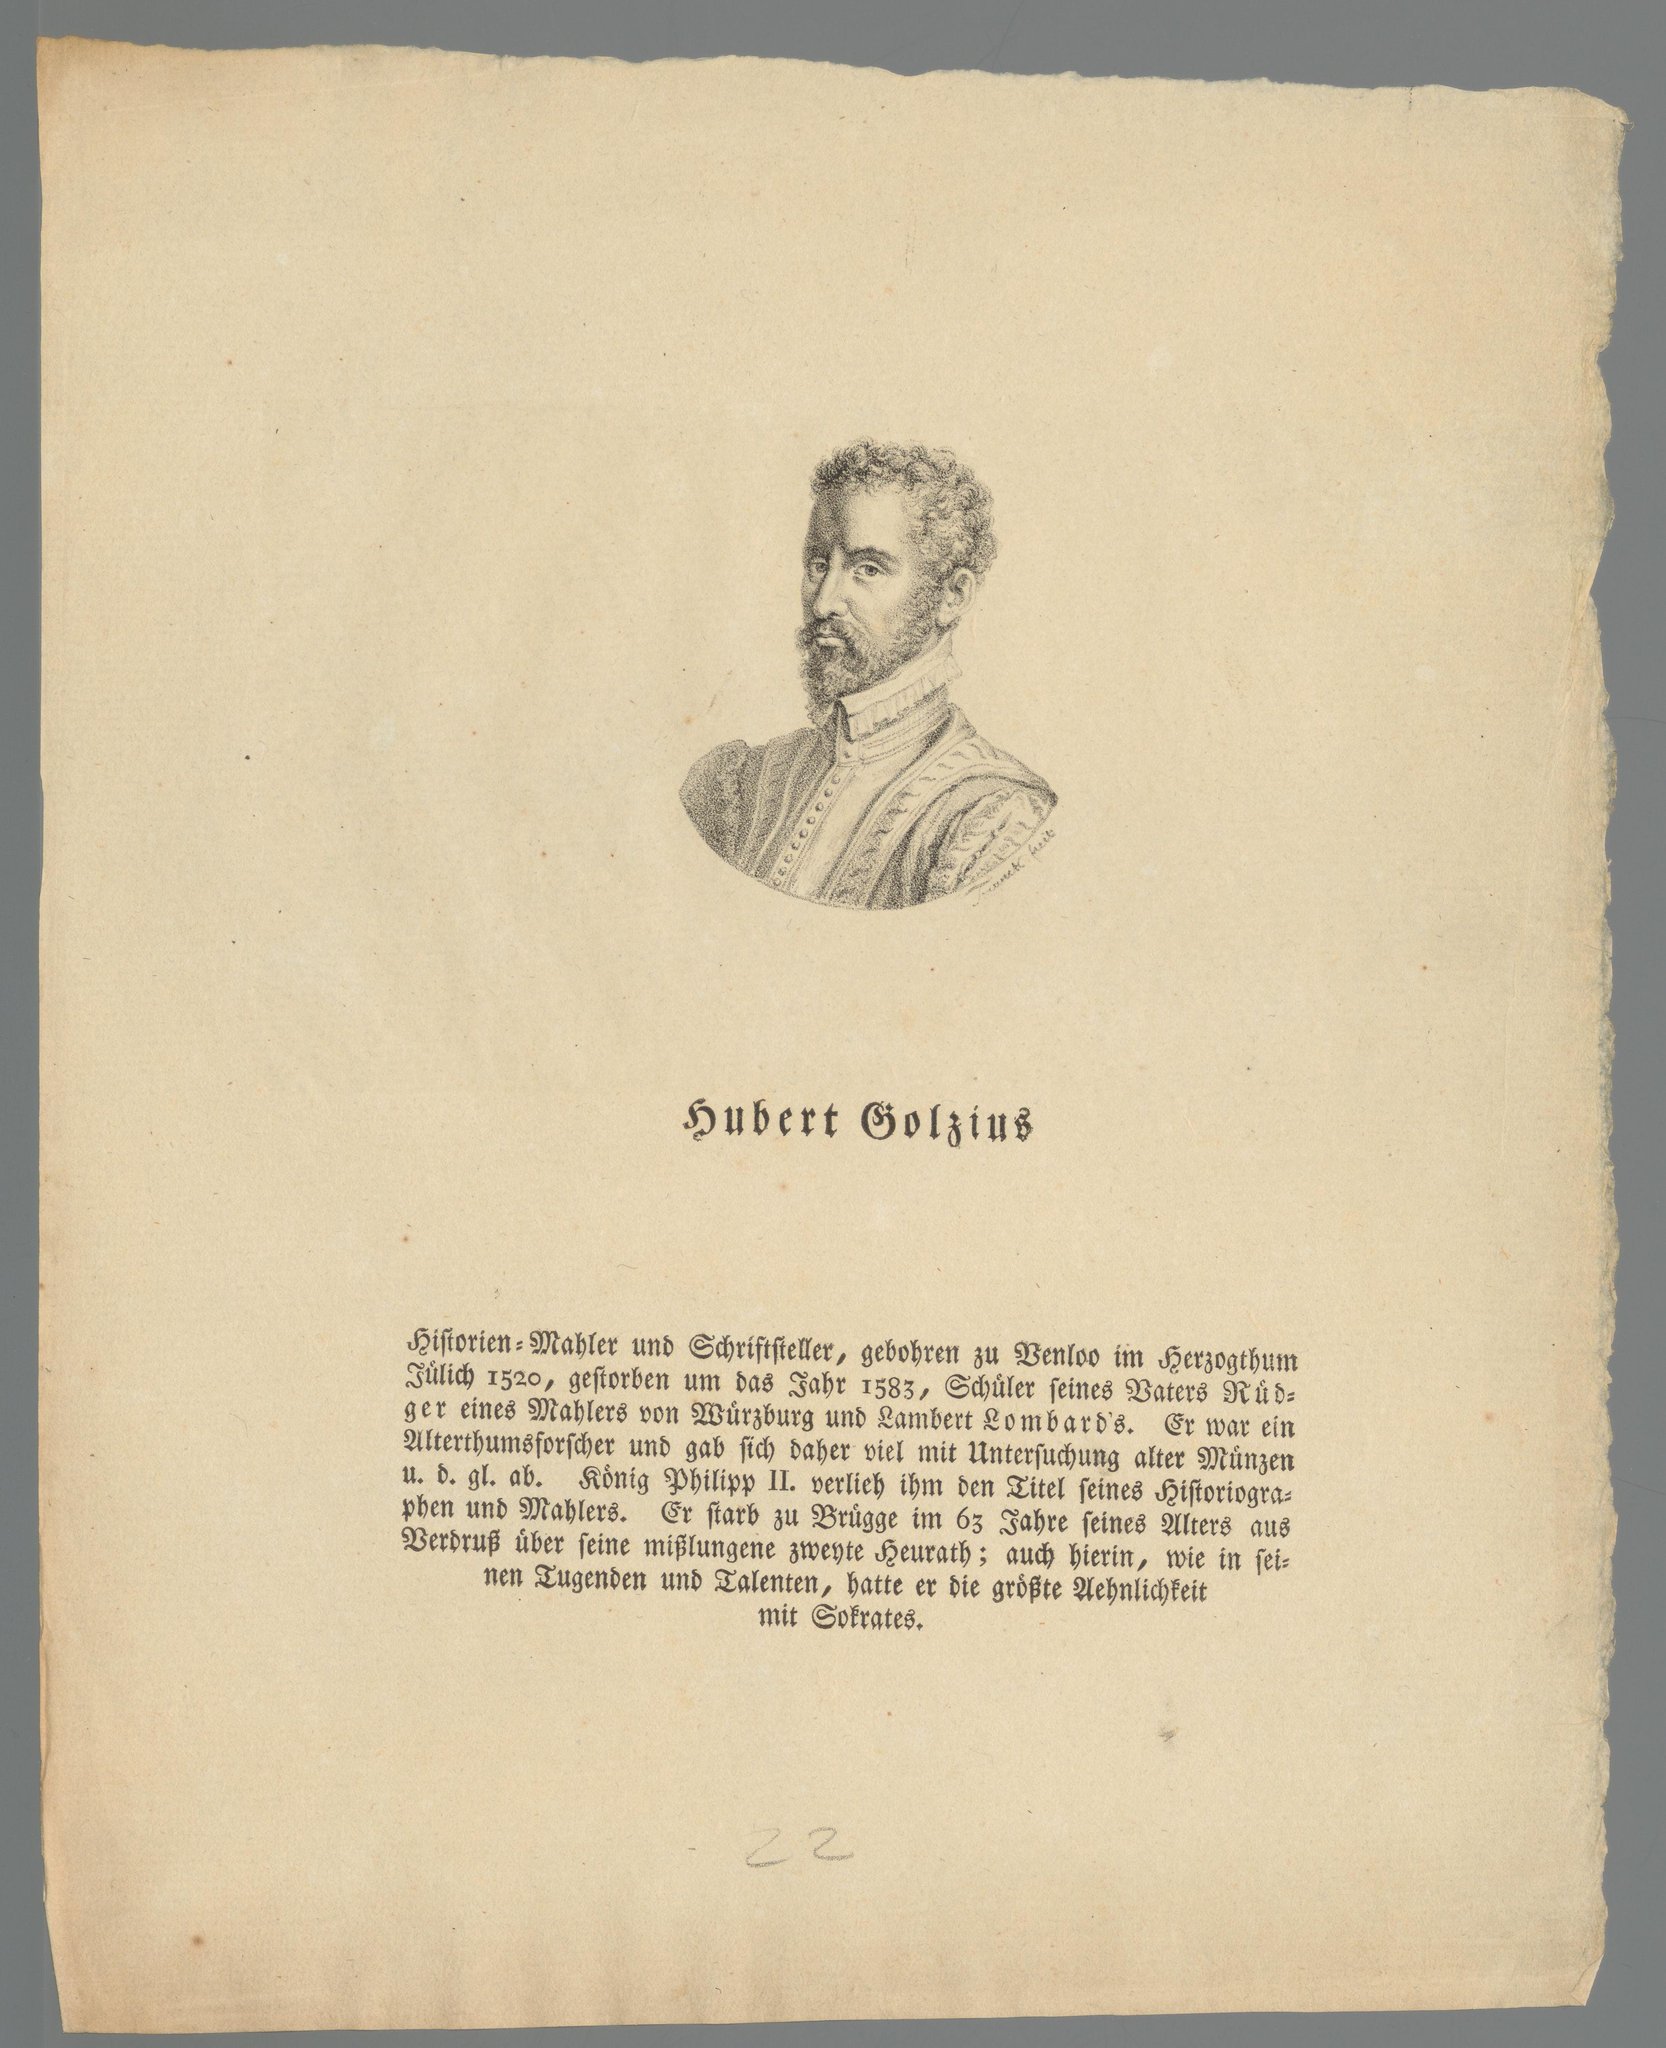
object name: print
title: Hubert Golzius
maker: maximilian franck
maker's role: print maker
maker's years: 1780-1830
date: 1813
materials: paper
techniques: letterpress printing, lithograph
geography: munich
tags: bruges, print maker, hubert goltzius, historical persons, portrait, self-portrait of graphic artist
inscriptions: collector's mark: Lugt 2228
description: Prent uit: Lindauer, Joseph. Deutsche Künstler-Gallerie. München: Maximilian Franck, 1813.